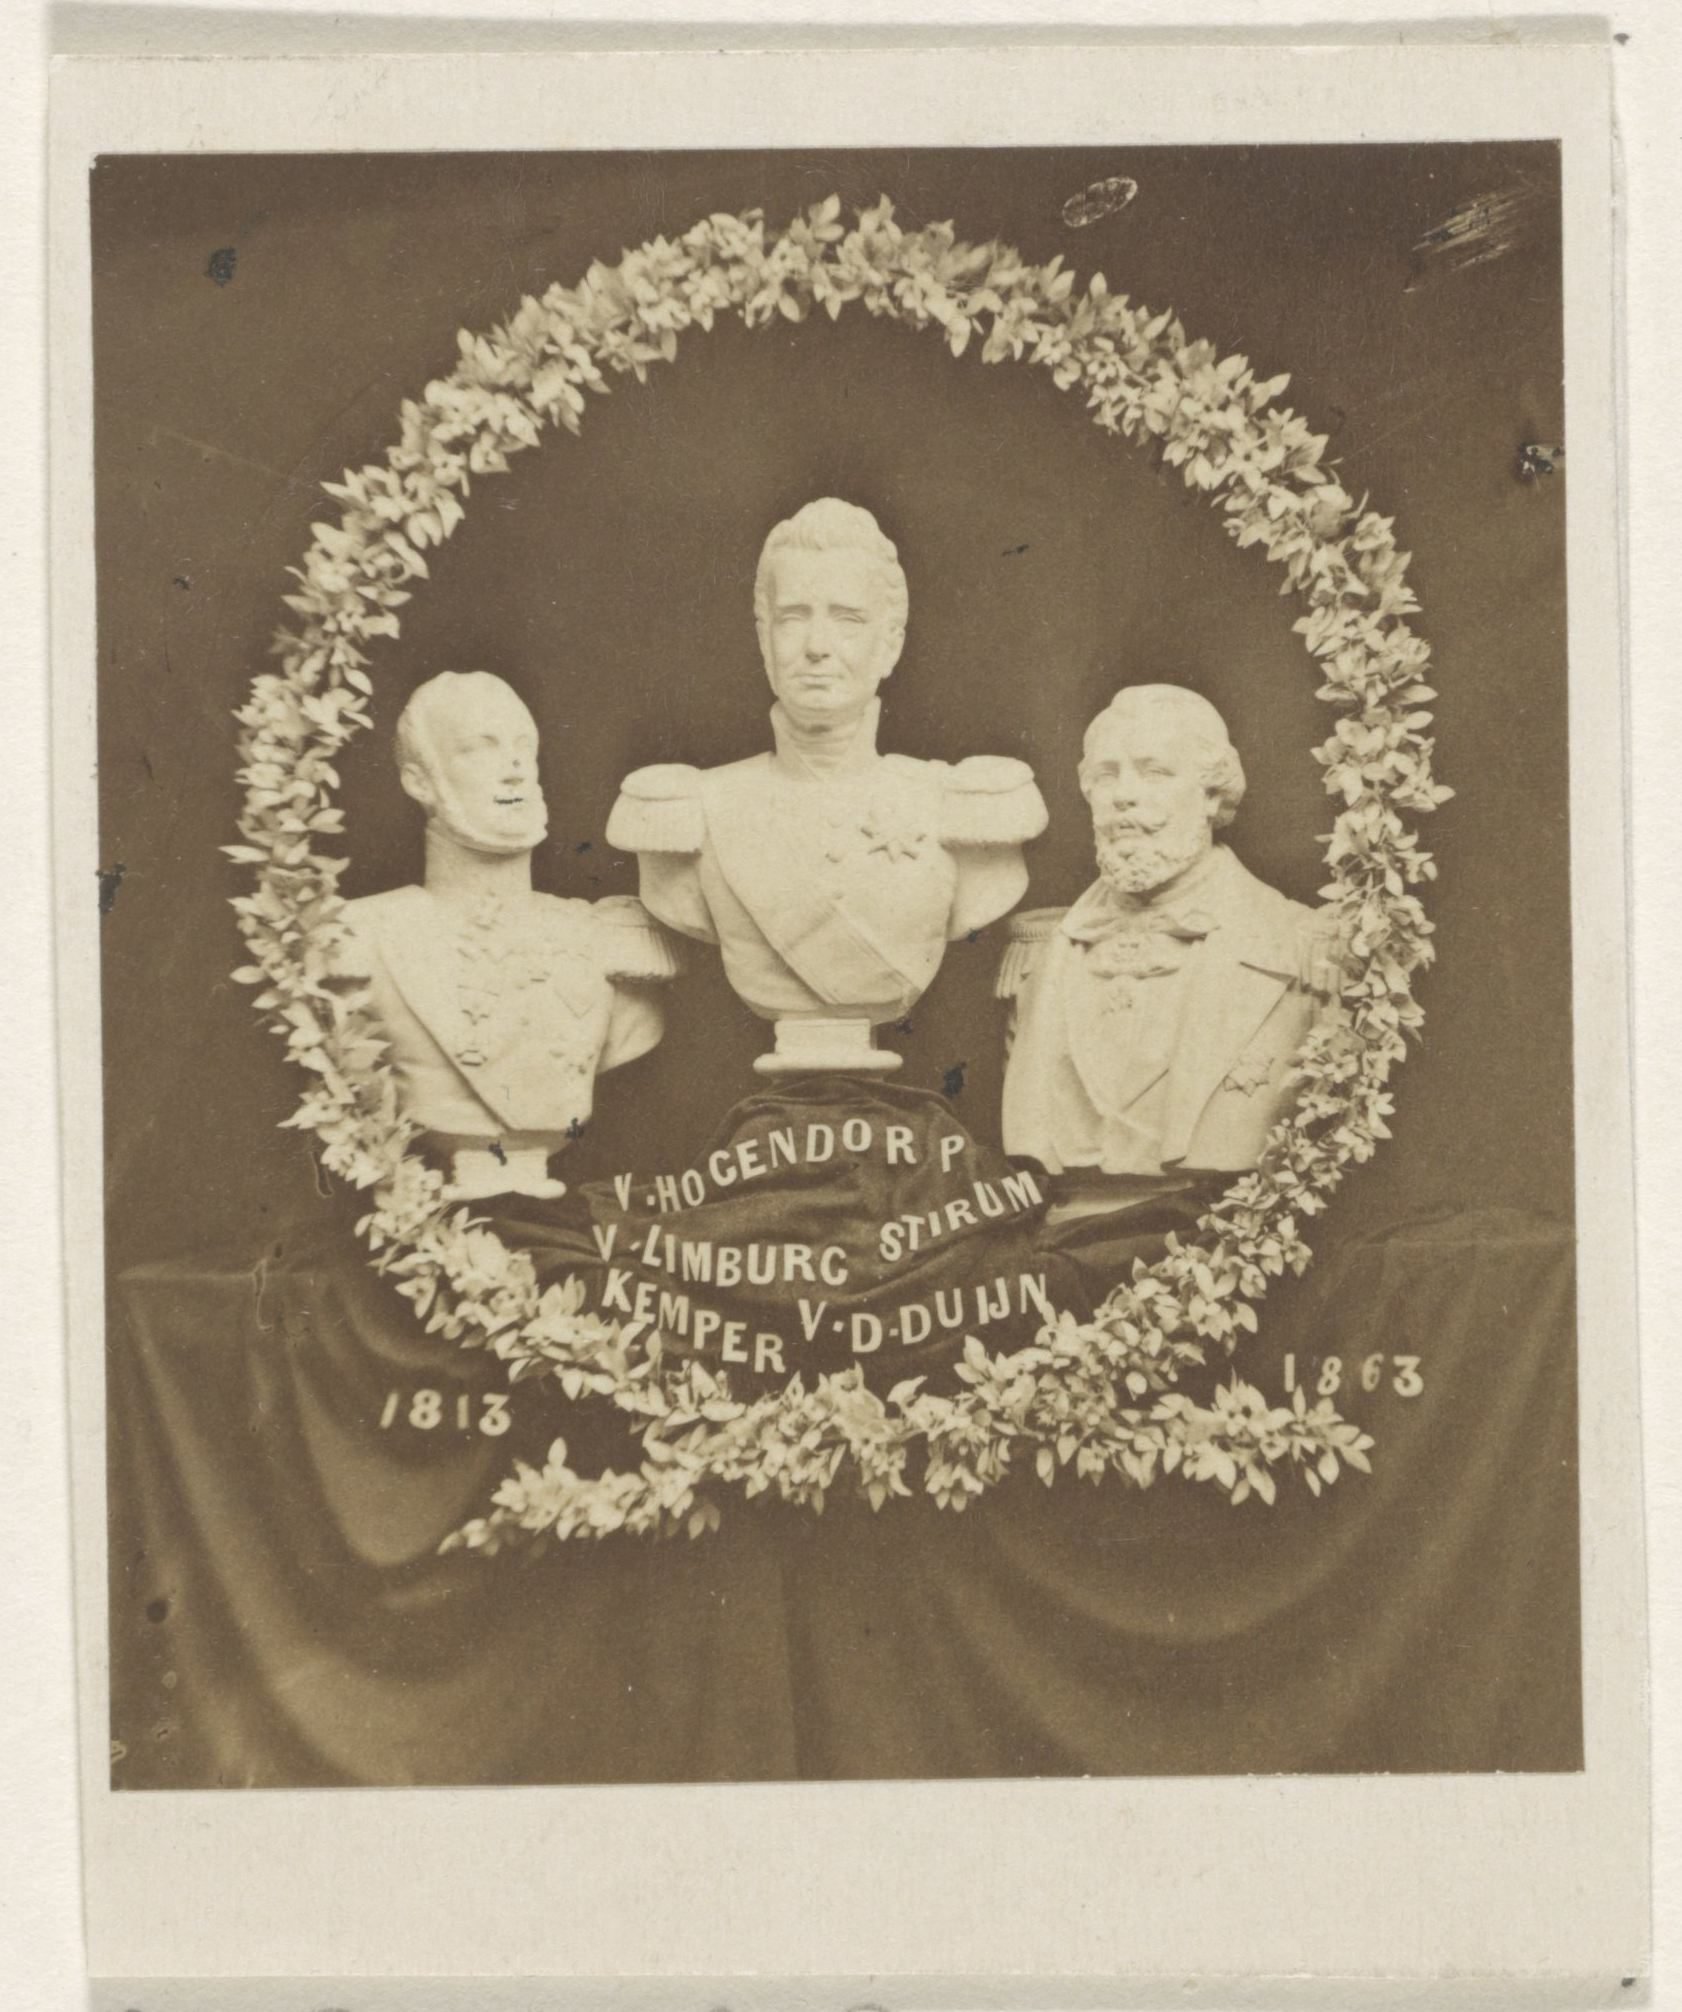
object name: photograph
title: Bustes van Gijsbert Karel, graaf van Hogendorp, Leopold, graaf van Limburg Stirum, en Adam François Jules Armand van der Duyn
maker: Anonymous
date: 1863-1930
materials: photographic support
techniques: photography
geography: netherlands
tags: rotterdam, the hague, gijsbert karel graaf van hogendorp, deventer, adam françois jules armand van der duyn, piece of sculpture, reproduction of a piece of sculpture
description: De hier vermelde titel verwijst naar de hoogst verkregen titel van de geportretteerde, niet per se naar de titel die de geportretteerde op deze voorstelling draagt.